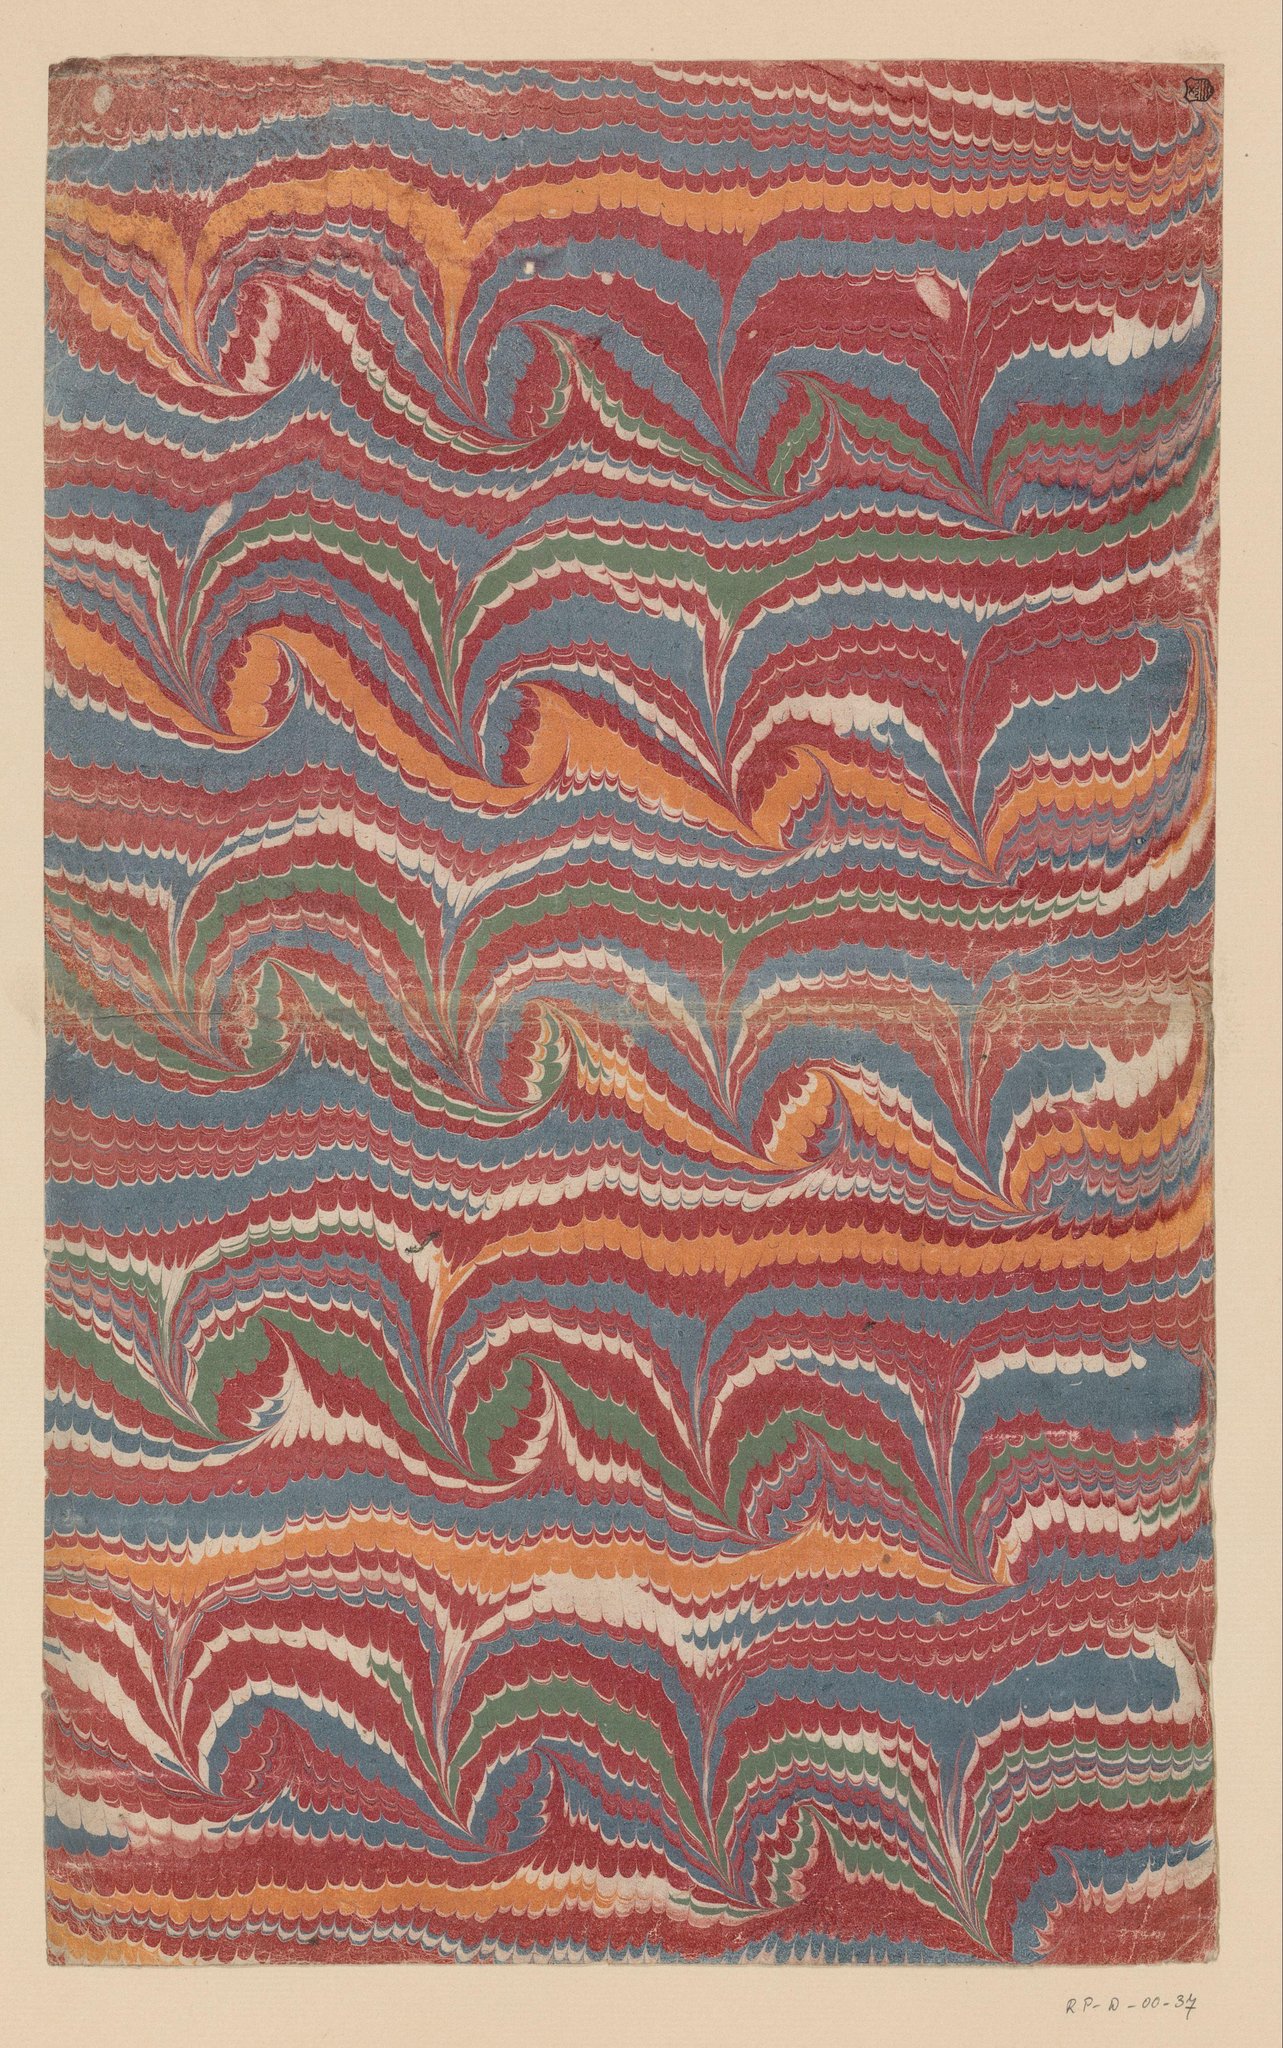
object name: wrapper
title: Spiraalkammarmer in rood, geel, blauw en groen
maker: Anonymous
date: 1700-1850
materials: paint, paper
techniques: marbled paper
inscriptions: collector's mark: Lugt 2760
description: Spiraalkammarmer in rood, geel, blauw en groen. Gebruikt als omslag.